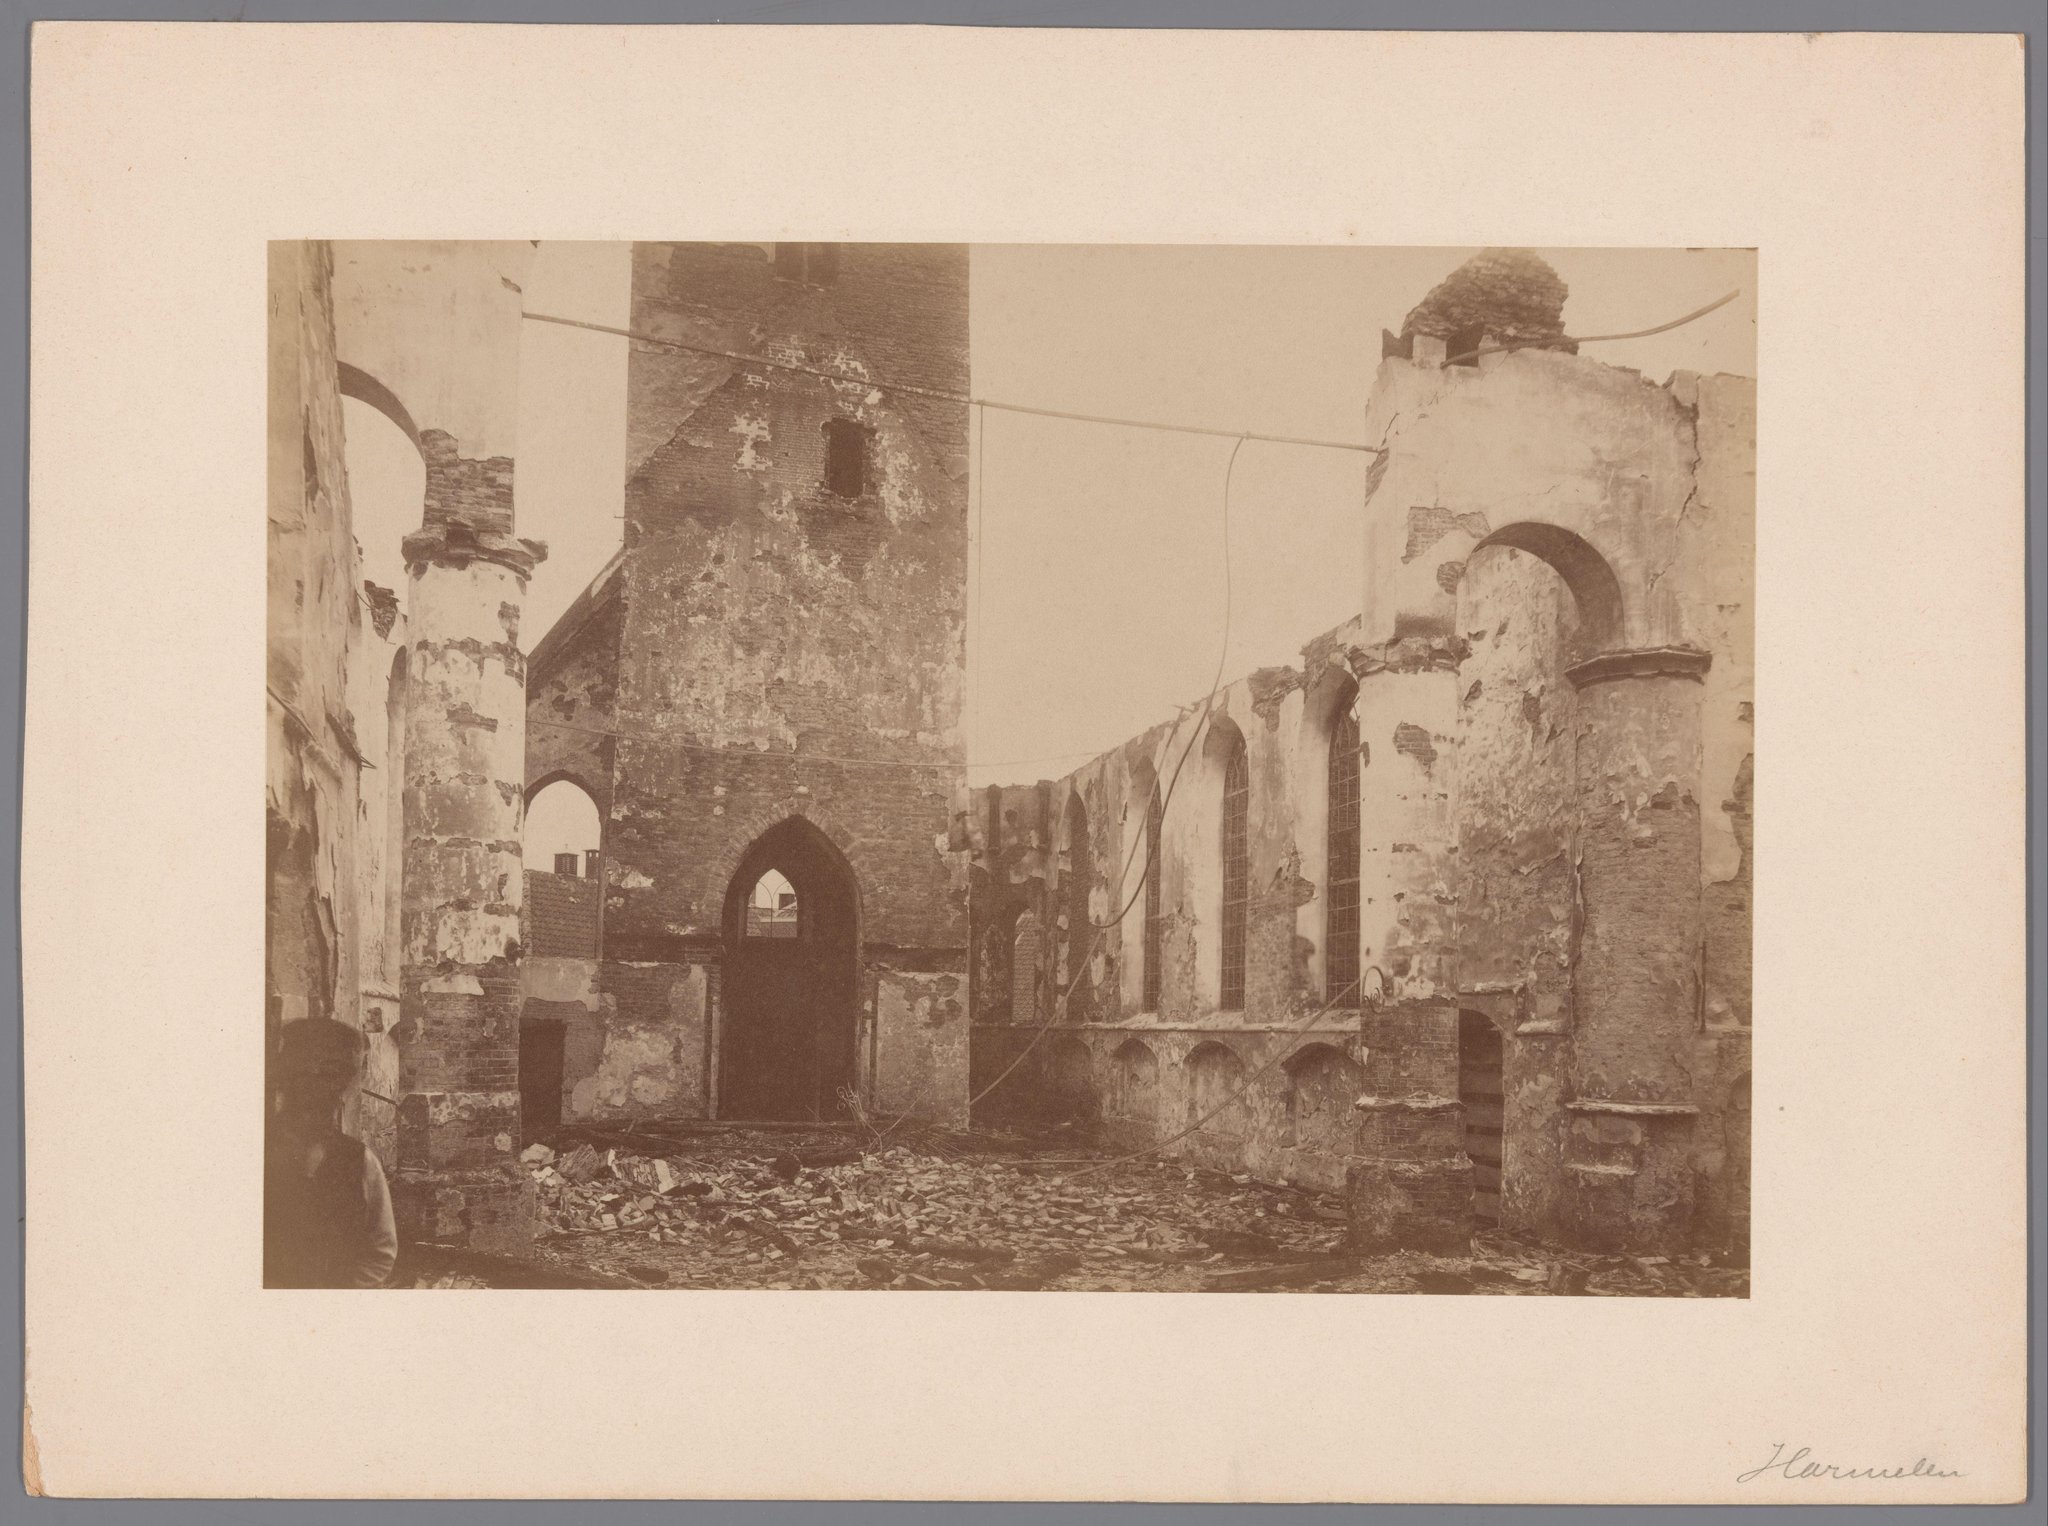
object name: photograph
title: Interieur de afgebrande Hervormde Kerk te Harmelen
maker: anoniem (monumentenzorg)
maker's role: fotograaf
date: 1900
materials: cardboard, photographic support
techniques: albumen print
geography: harmelen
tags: interior of church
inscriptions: annotation: ‘Kerk der N.H. gemeente te Harmelen (U.)/ na den brand in juni 1900/ geizen naar het westen’, annotation: ‘Harmelen’